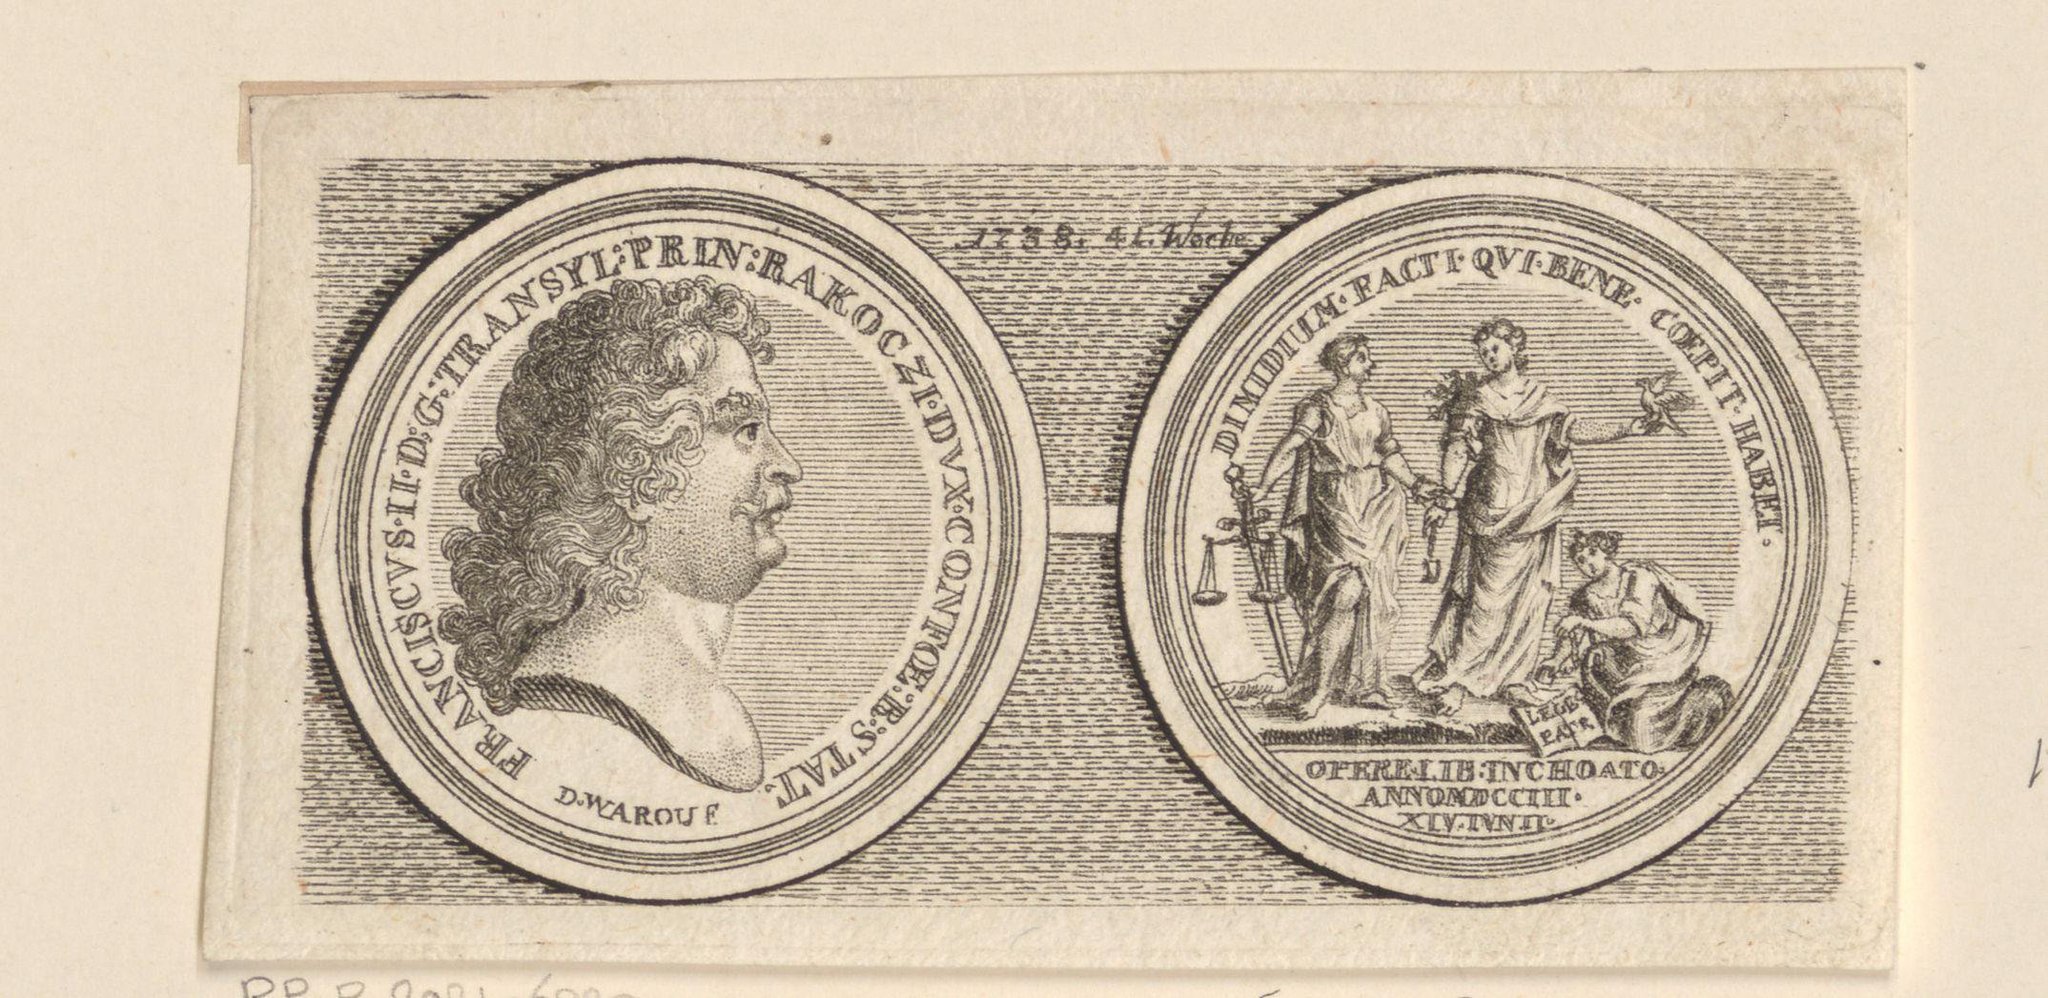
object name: print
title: Portret van Frans Ragotzky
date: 1738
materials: paper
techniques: etching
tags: historical persons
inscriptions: date